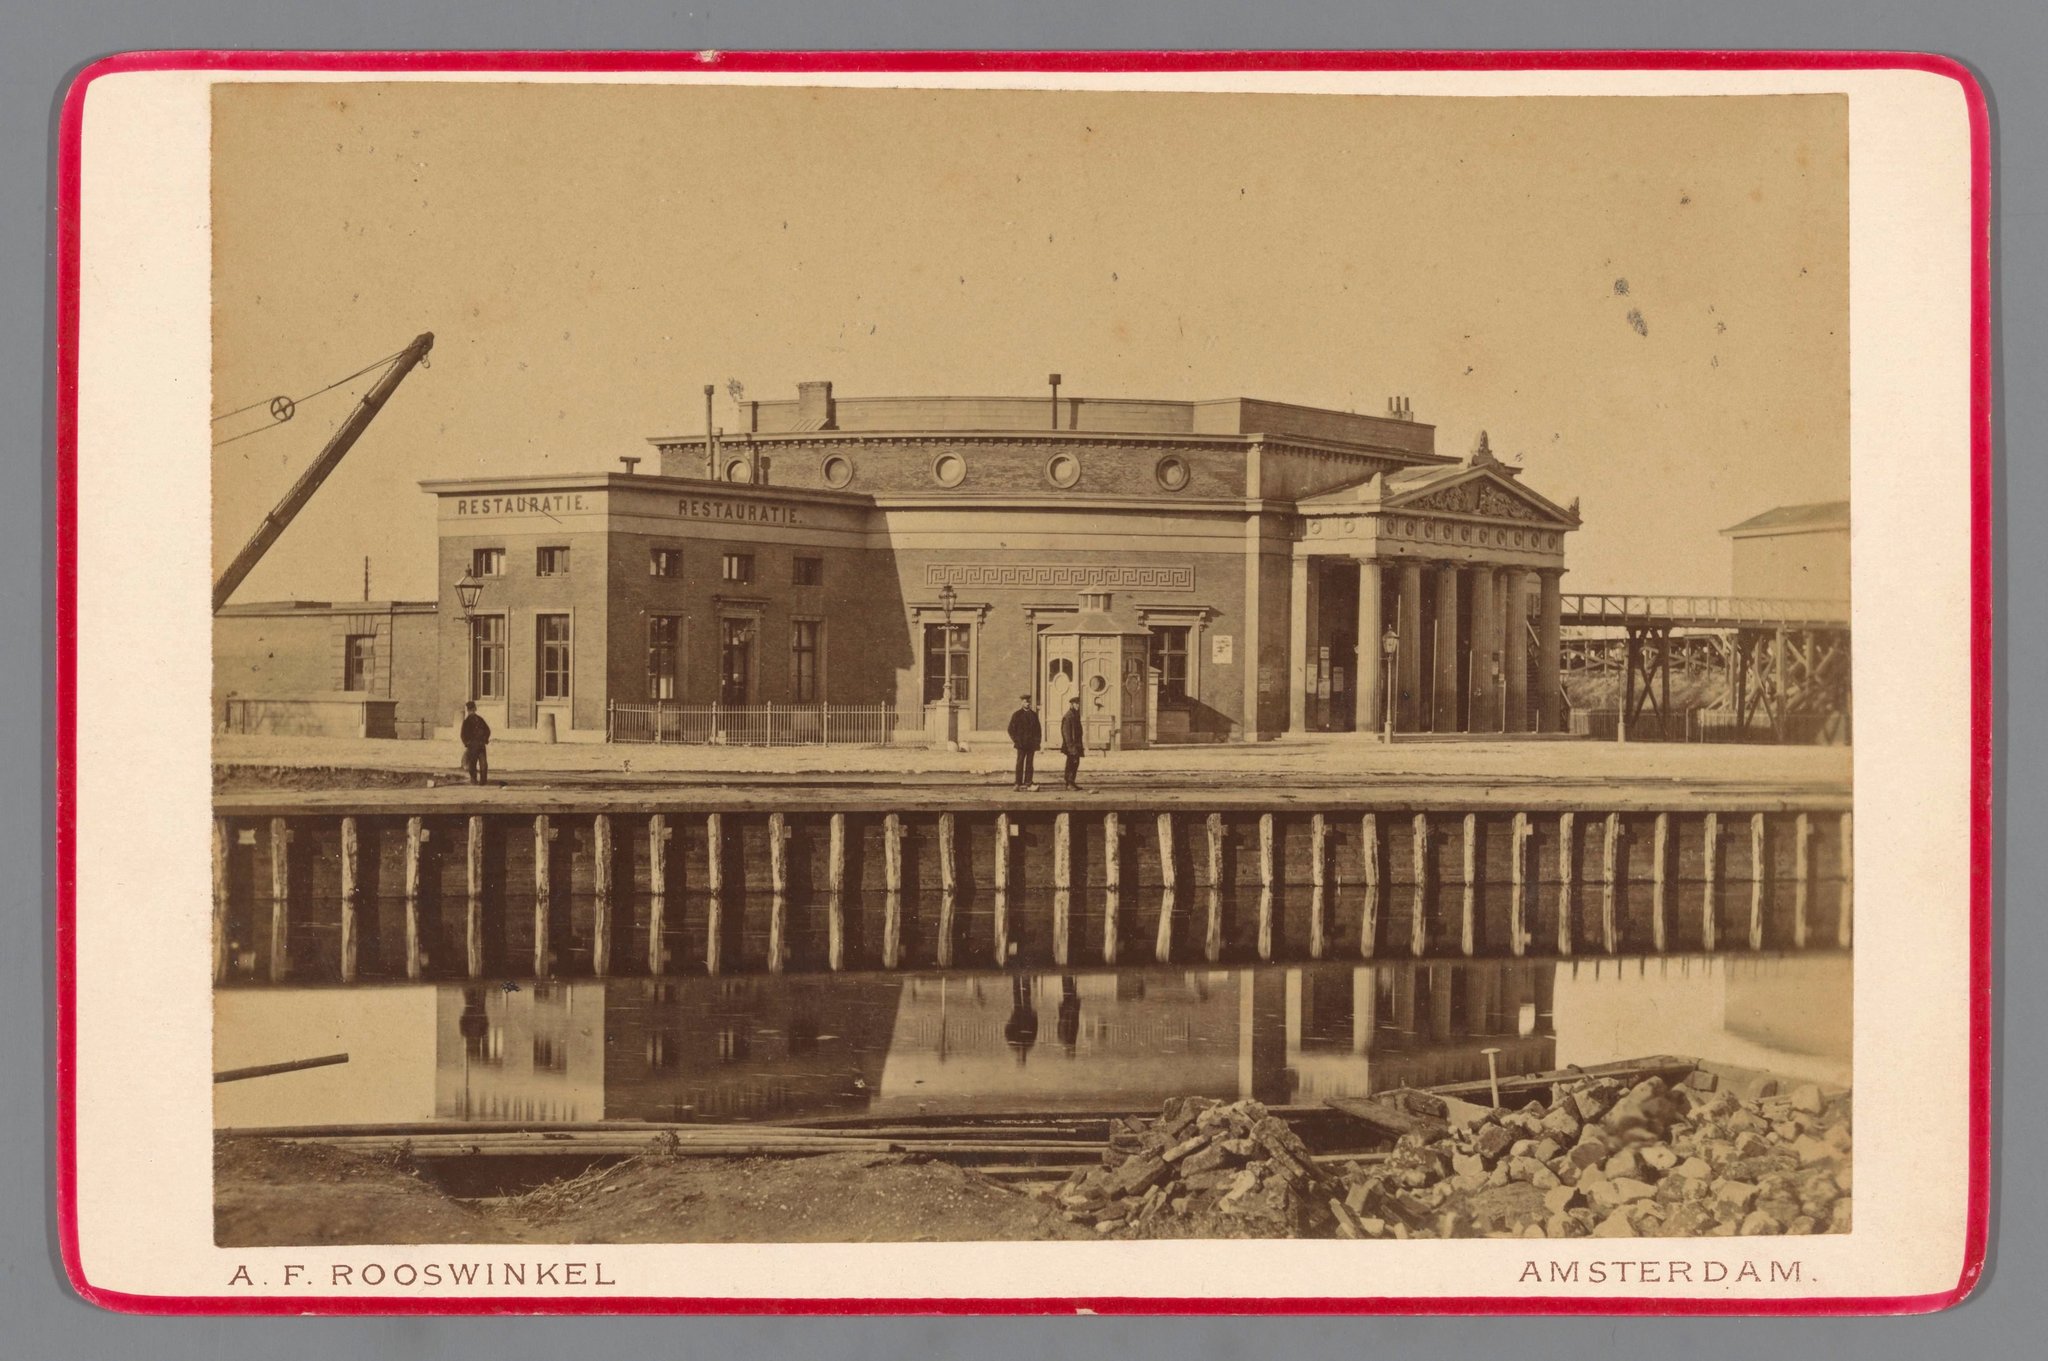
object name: cabinet photograph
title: Gezicht op Station Amsterdam Willemspoort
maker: andreas theodorus rooswinkel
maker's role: fotograaf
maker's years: 1838-1909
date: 1867-1878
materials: cardboard, photographic support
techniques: albumen print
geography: amsterdam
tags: station; shelter (railway, tramway)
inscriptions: inscription: ‘Voormalige Station/ Hollandsche Spoorweg/ aan de Haarlemmervaart/ (Willemspoort)/ gesloopt 1878’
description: Op de voorgrond de Haarlemmer Trekvaart.